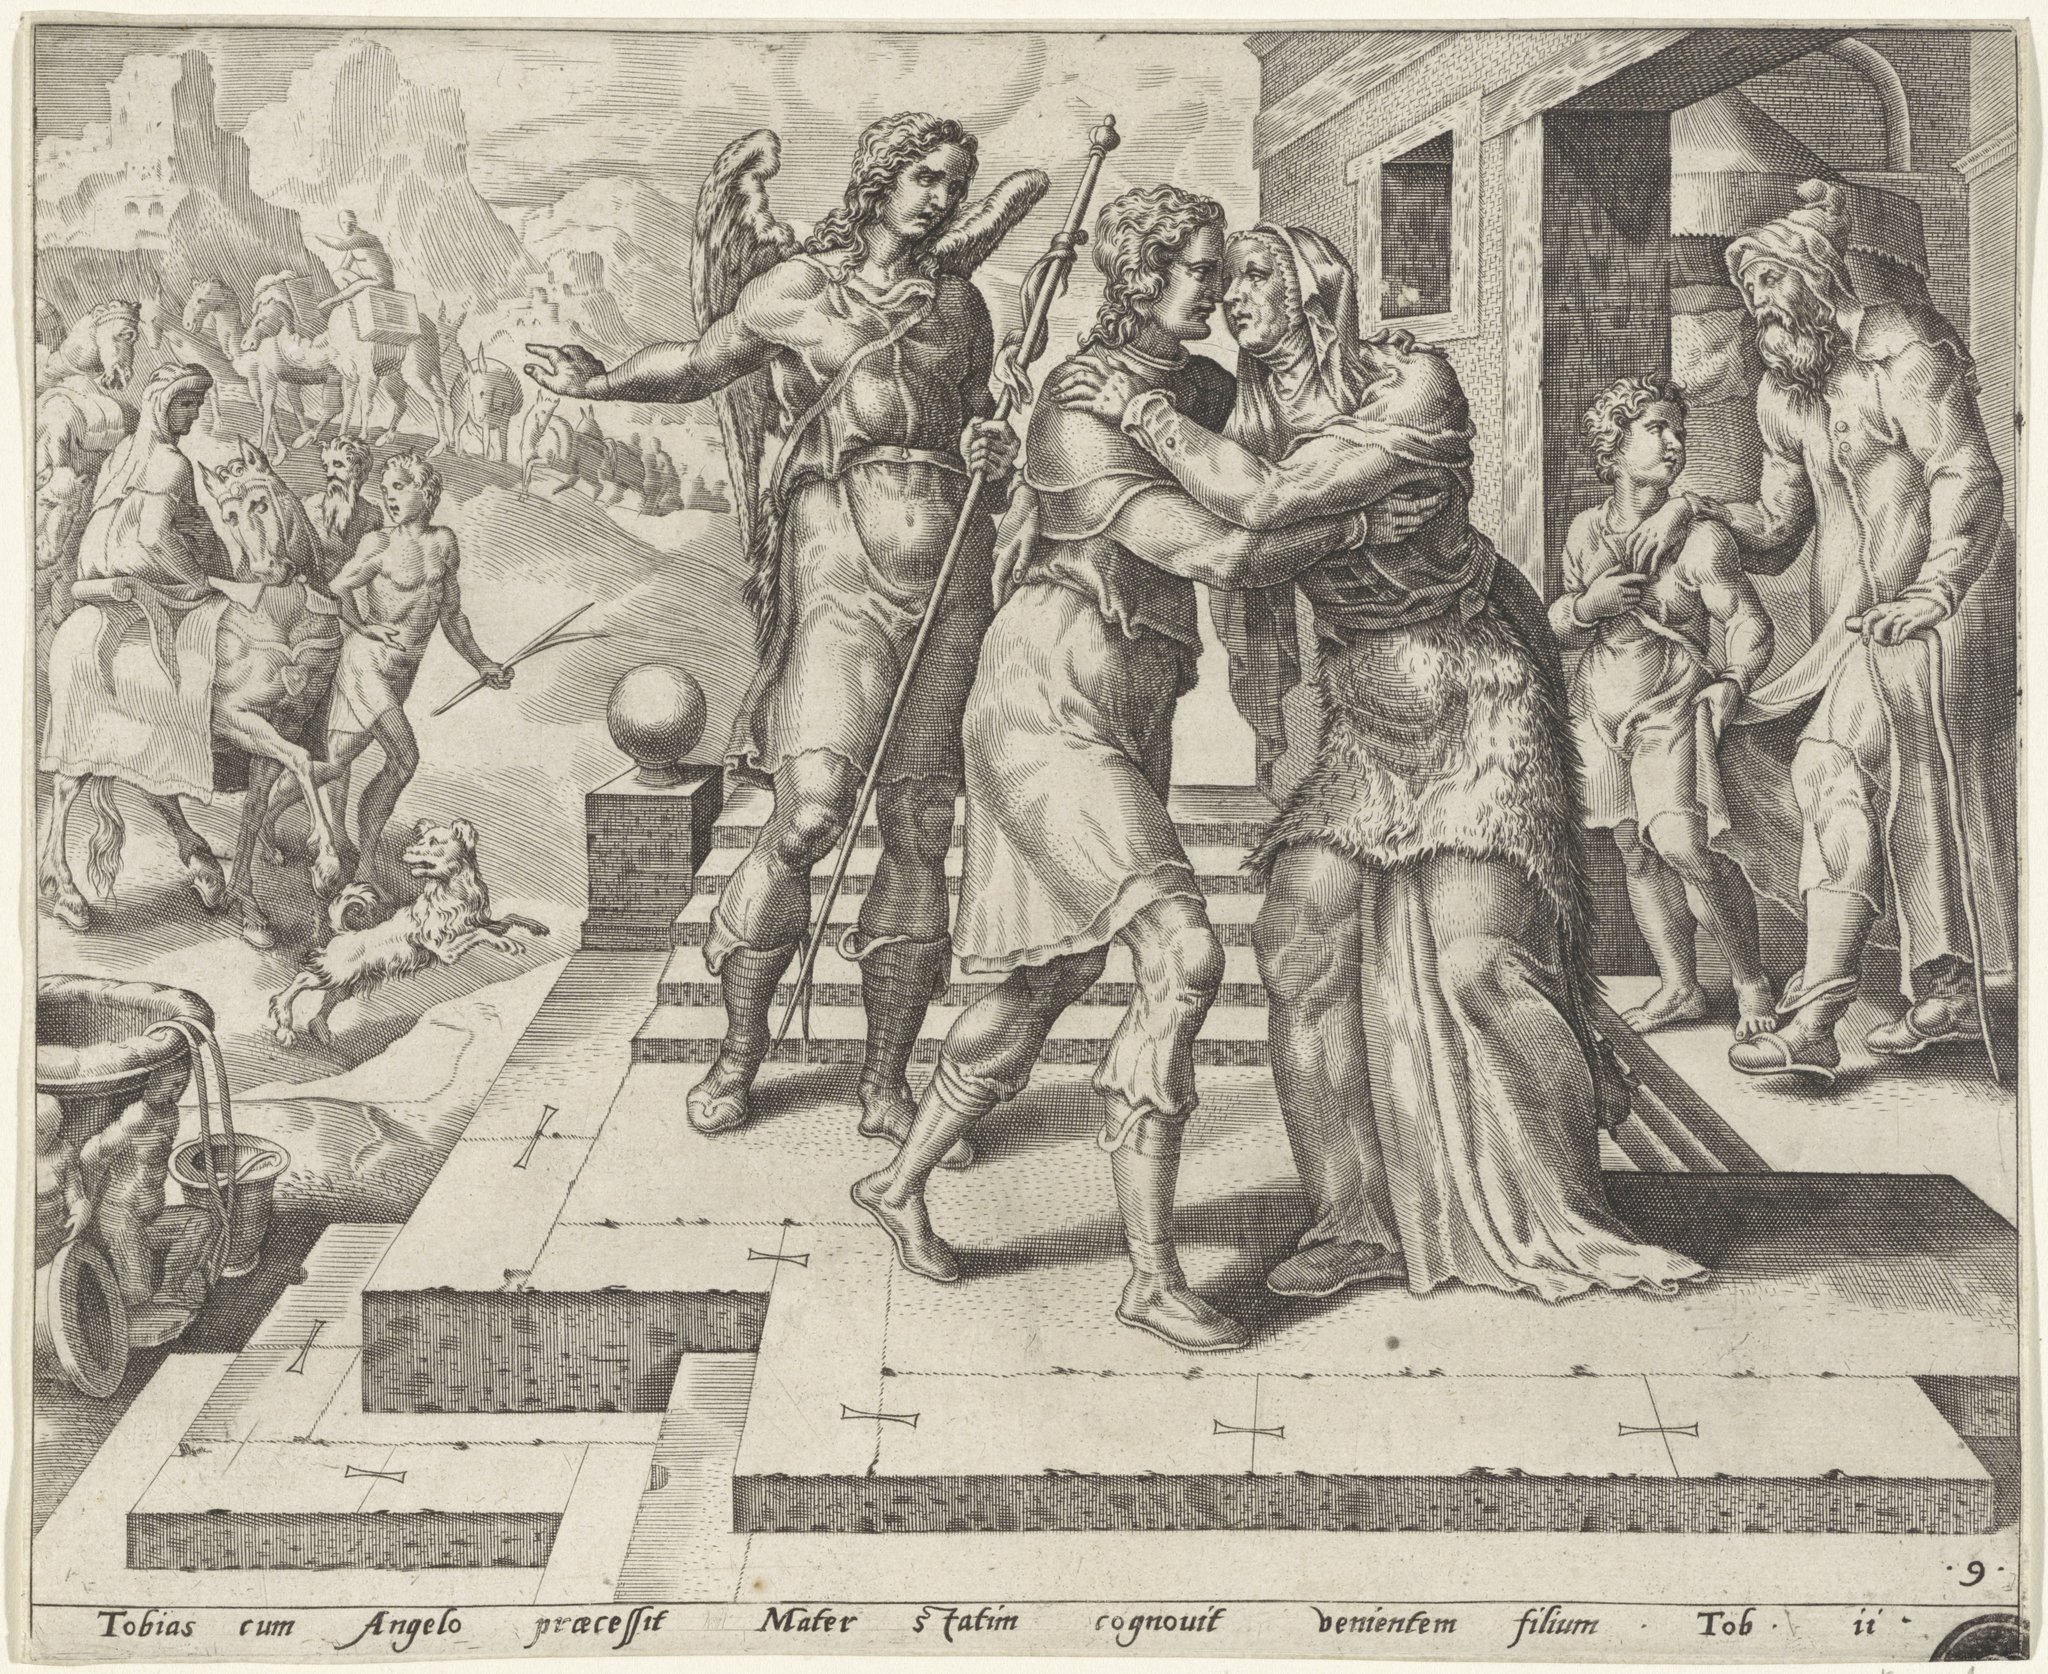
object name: print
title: Verhaal van Tobias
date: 1556-1633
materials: paper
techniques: engraving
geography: low countries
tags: the meeting of parents and son ~ tobias' return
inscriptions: collector's mark: Lugt 2228, collector's mark, collector's mark: Lugt 2760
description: Tobias omhelst zijn moeder Anna bij thuiskomst. Achter haar leidt een jongen de blinde Tobit naar buiten. De aartsengel Rafaël wijst in de richting van Sara en de met geschenken bepakte dieren. Onderaan in de marge een éénregelig onderschrift in het Latijn uit Tobit 11.